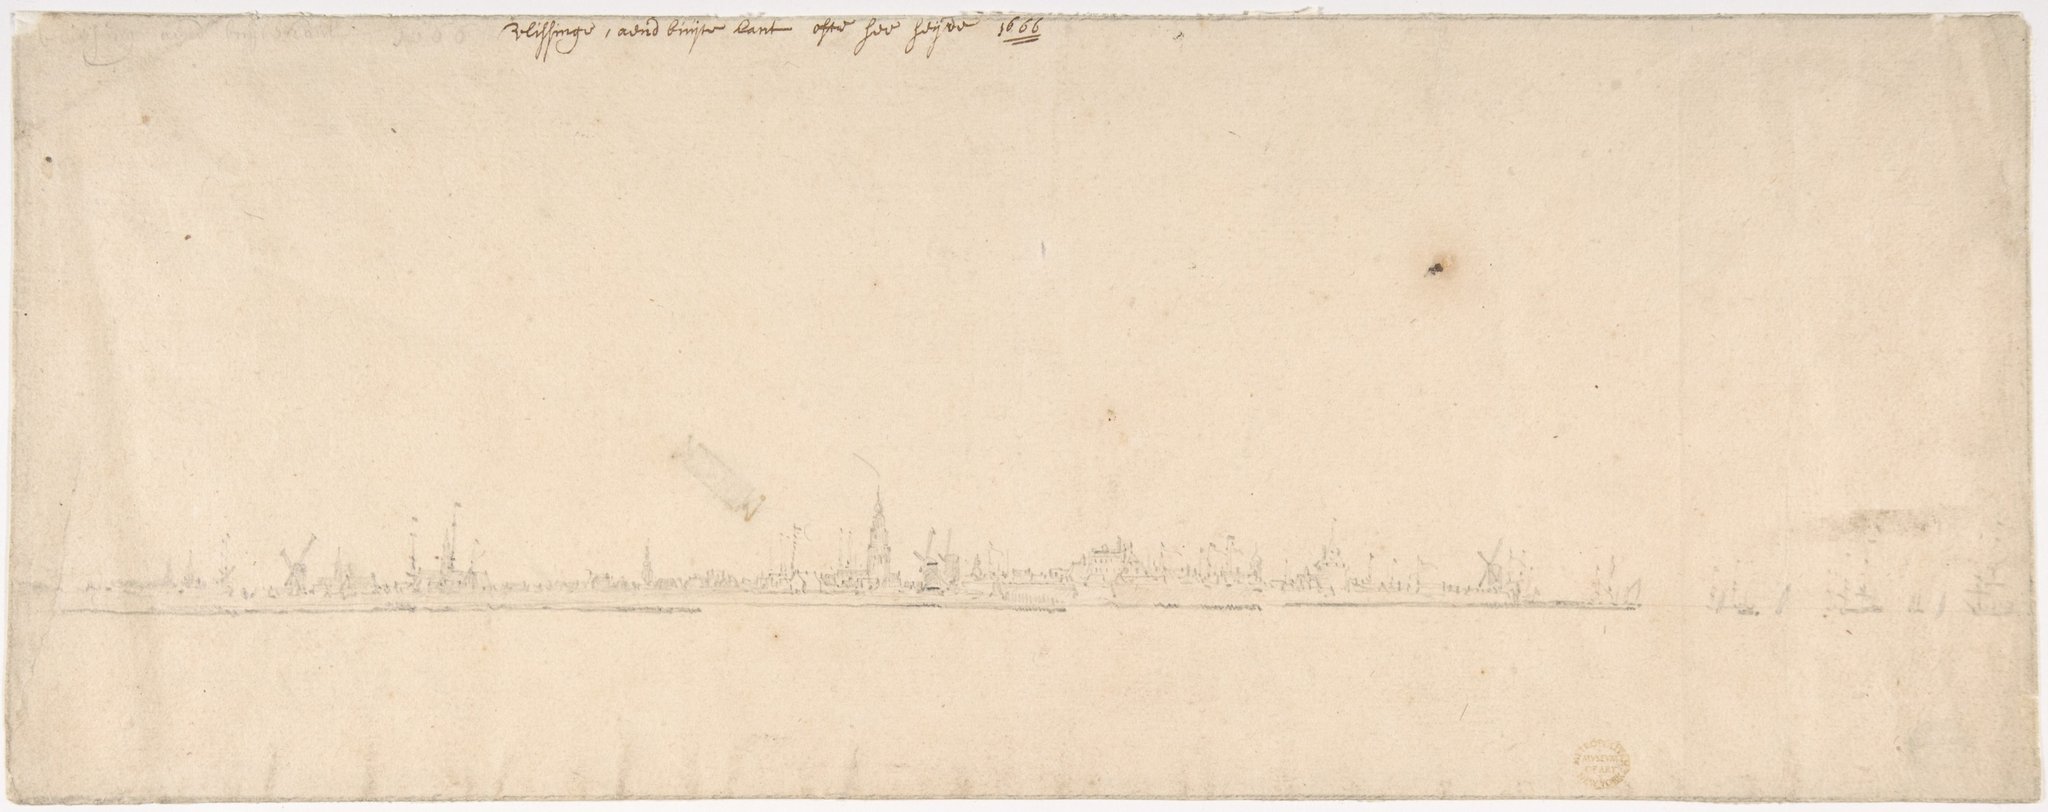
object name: drawing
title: Flushing from the Sea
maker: willem van de velde (ii)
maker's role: artist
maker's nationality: dutch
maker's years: 1633-1707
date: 1634-1733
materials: graphite, paper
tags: cities